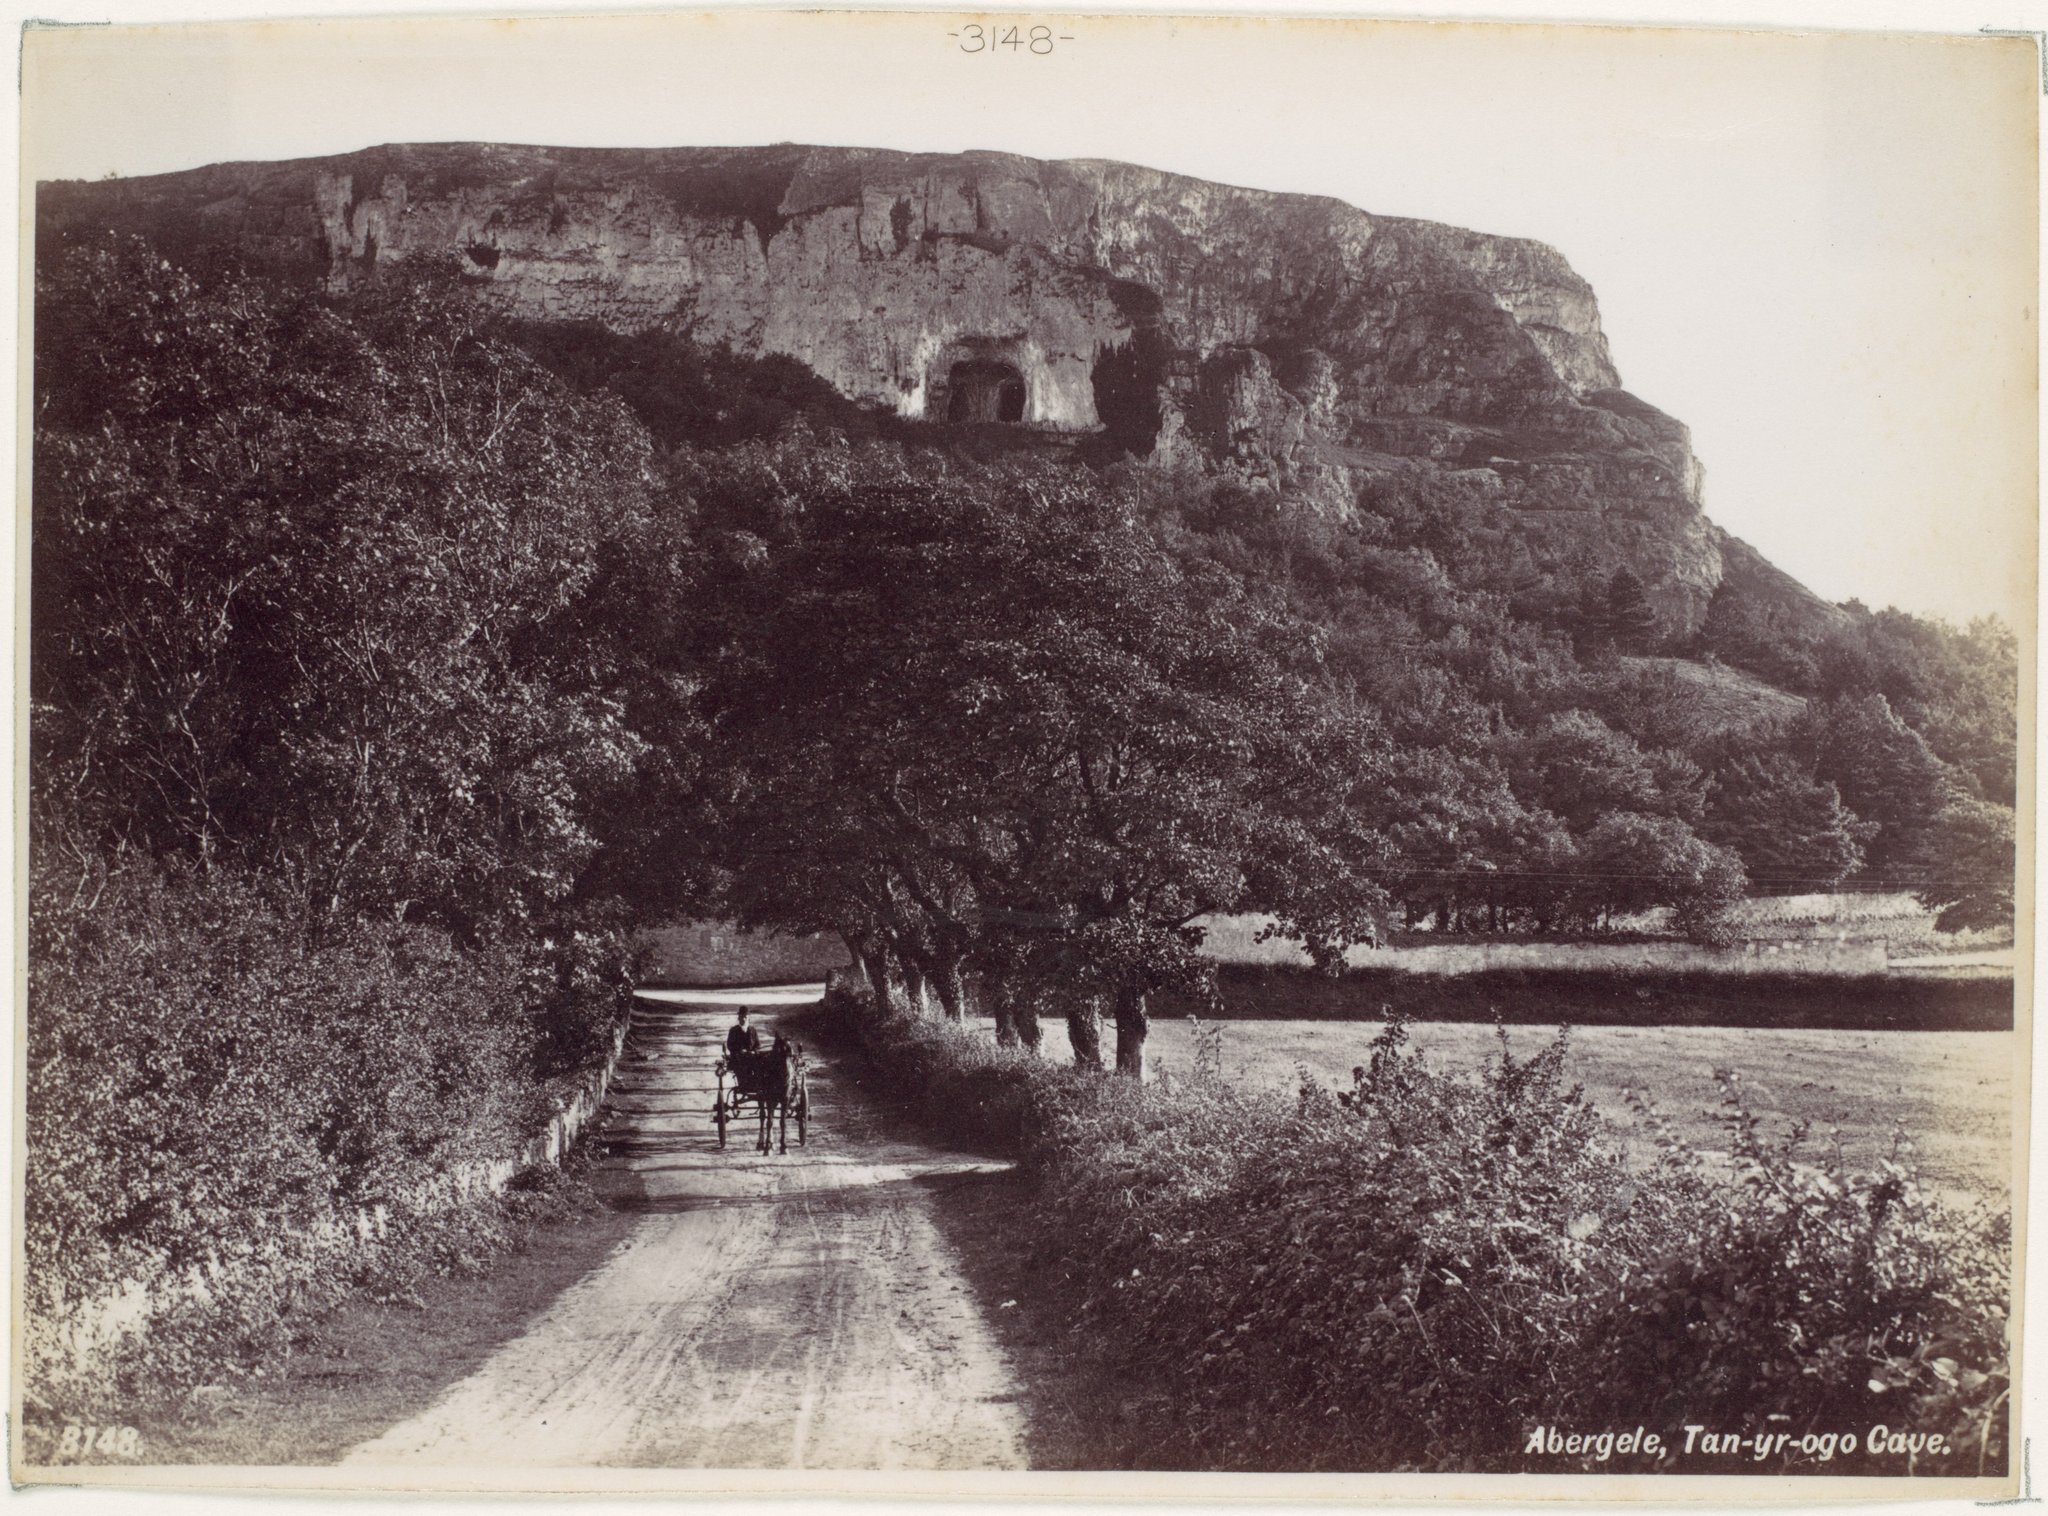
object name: photograph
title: Abergele, Tan-yr-ogo Cave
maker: francis bedford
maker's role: artist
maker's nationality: british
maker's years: 1816-1894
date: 1870-1879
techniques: albumen silver print, glass negative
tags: landscapes,carriages